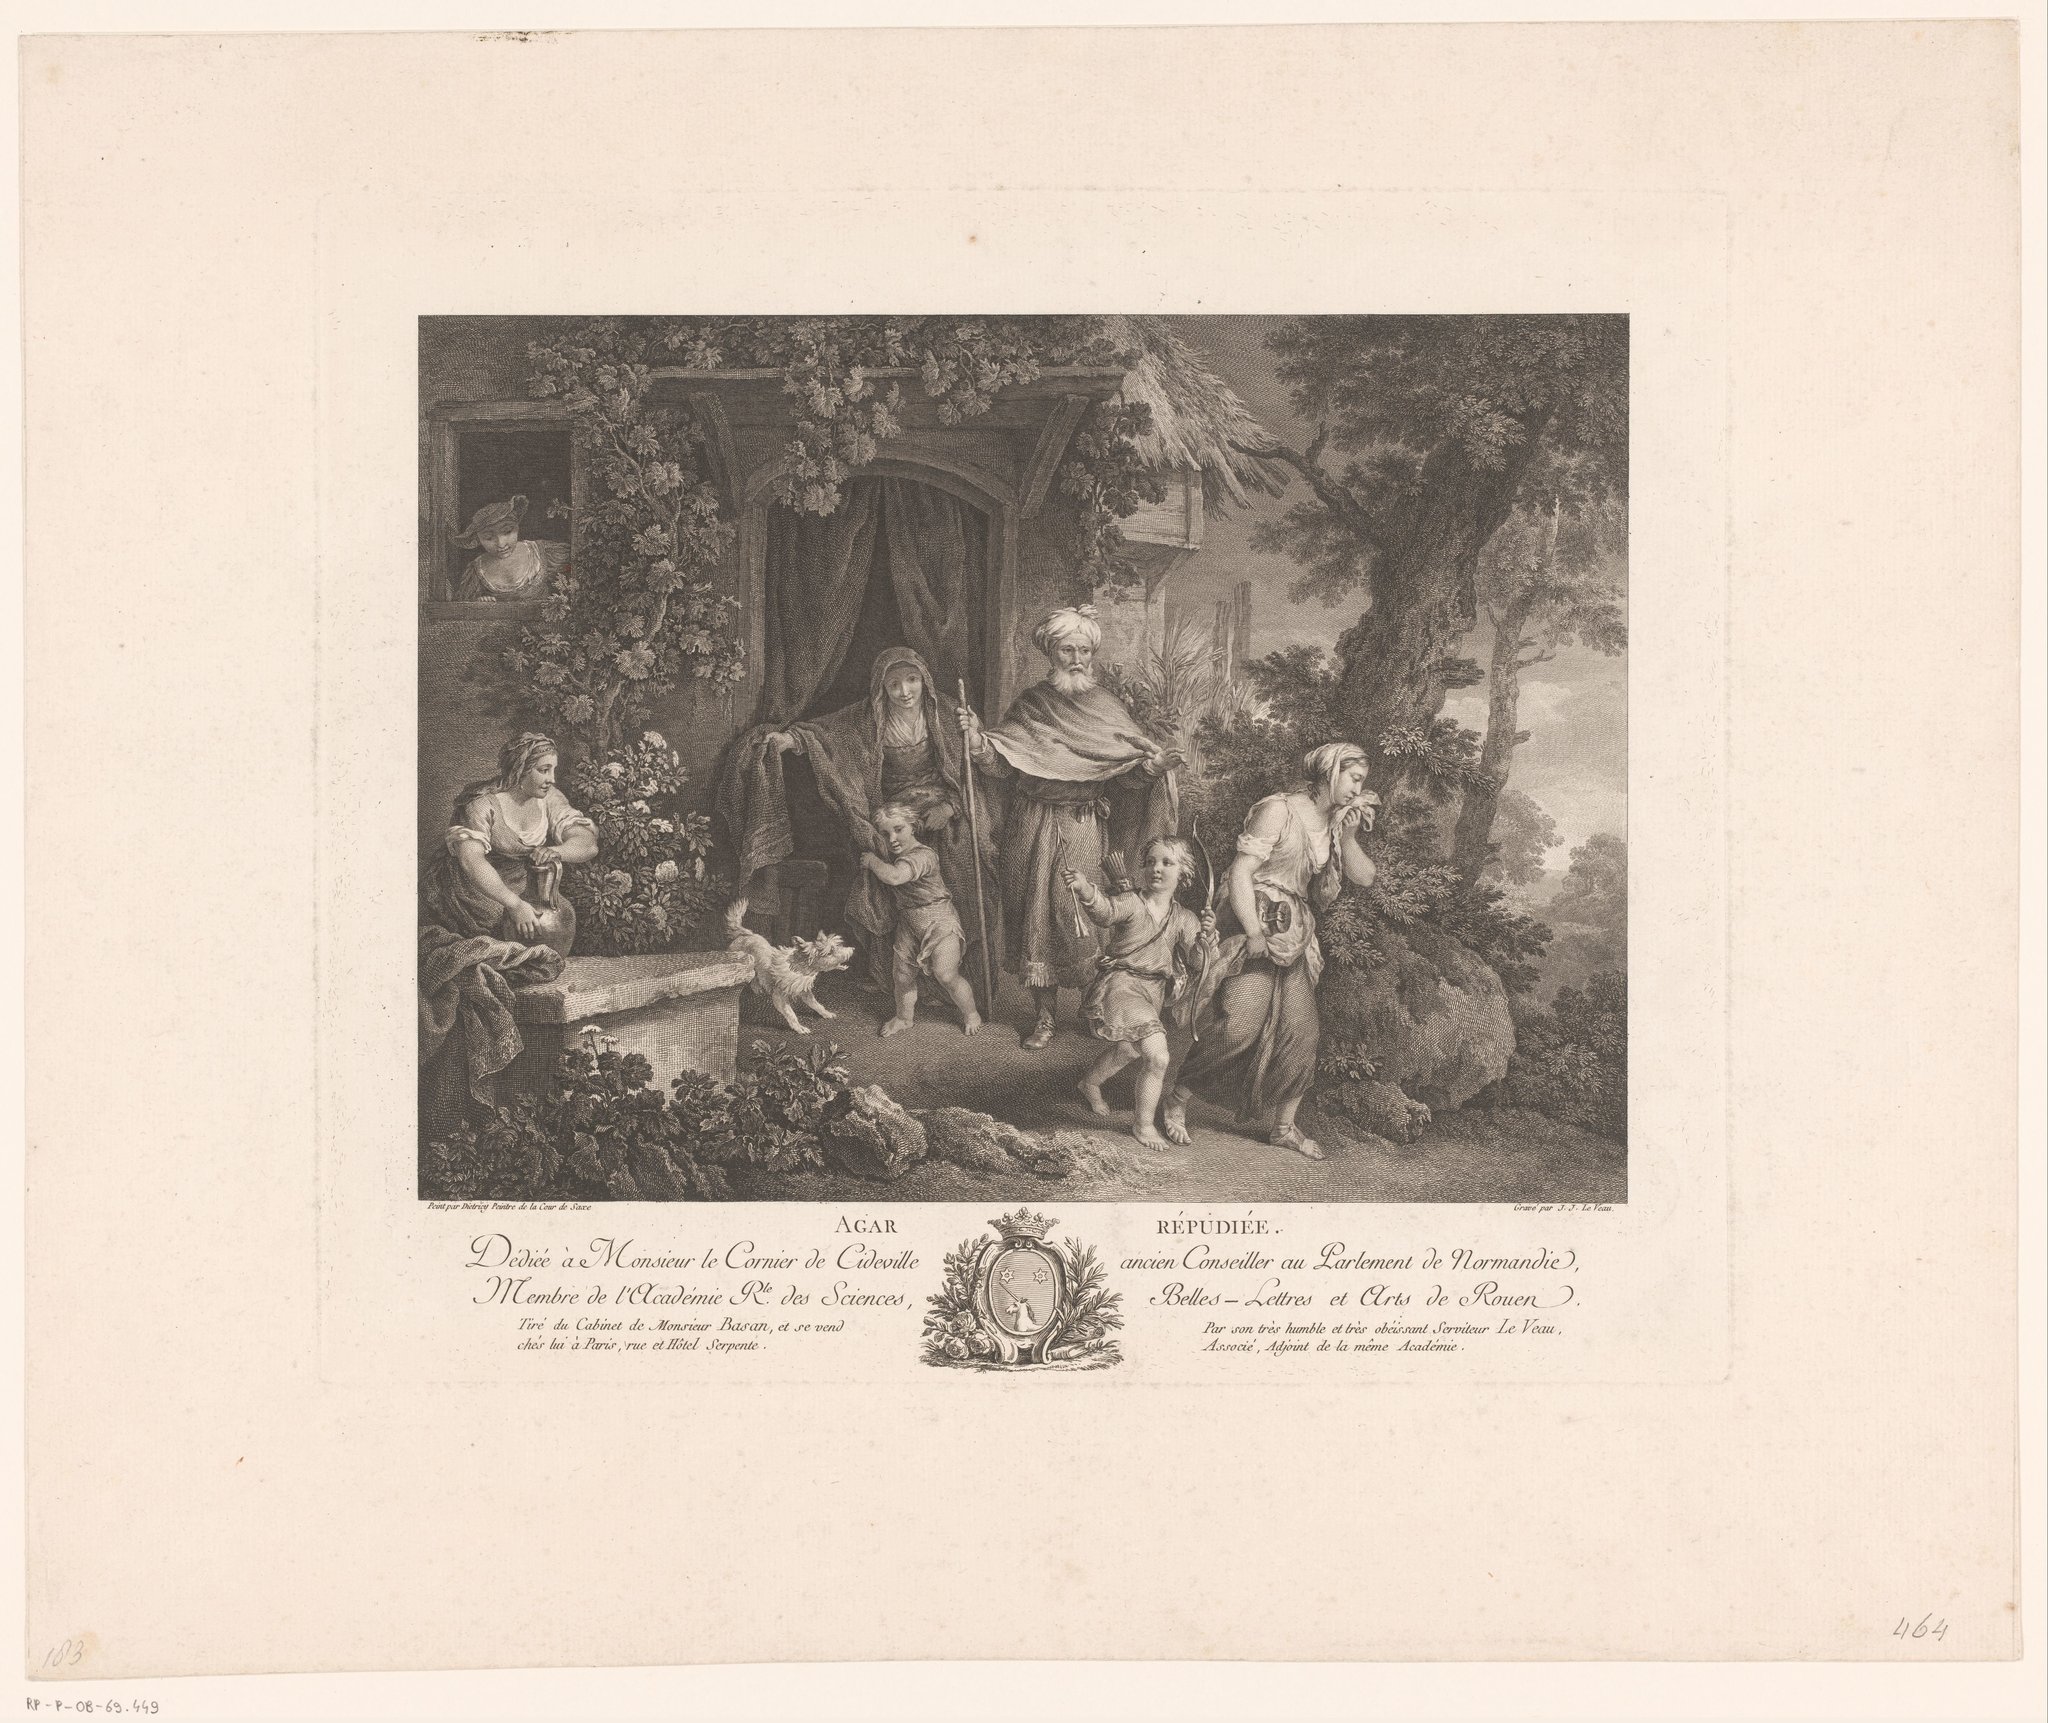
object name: print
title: Agar Répudiée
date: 1739-1786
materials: paper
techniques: engraving, etching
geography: france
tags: unicorn, the banishment of hagar and ishmael (genesis 21:9-21), armorial bearing, heraldry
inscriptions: collector's mark: Lugt 240